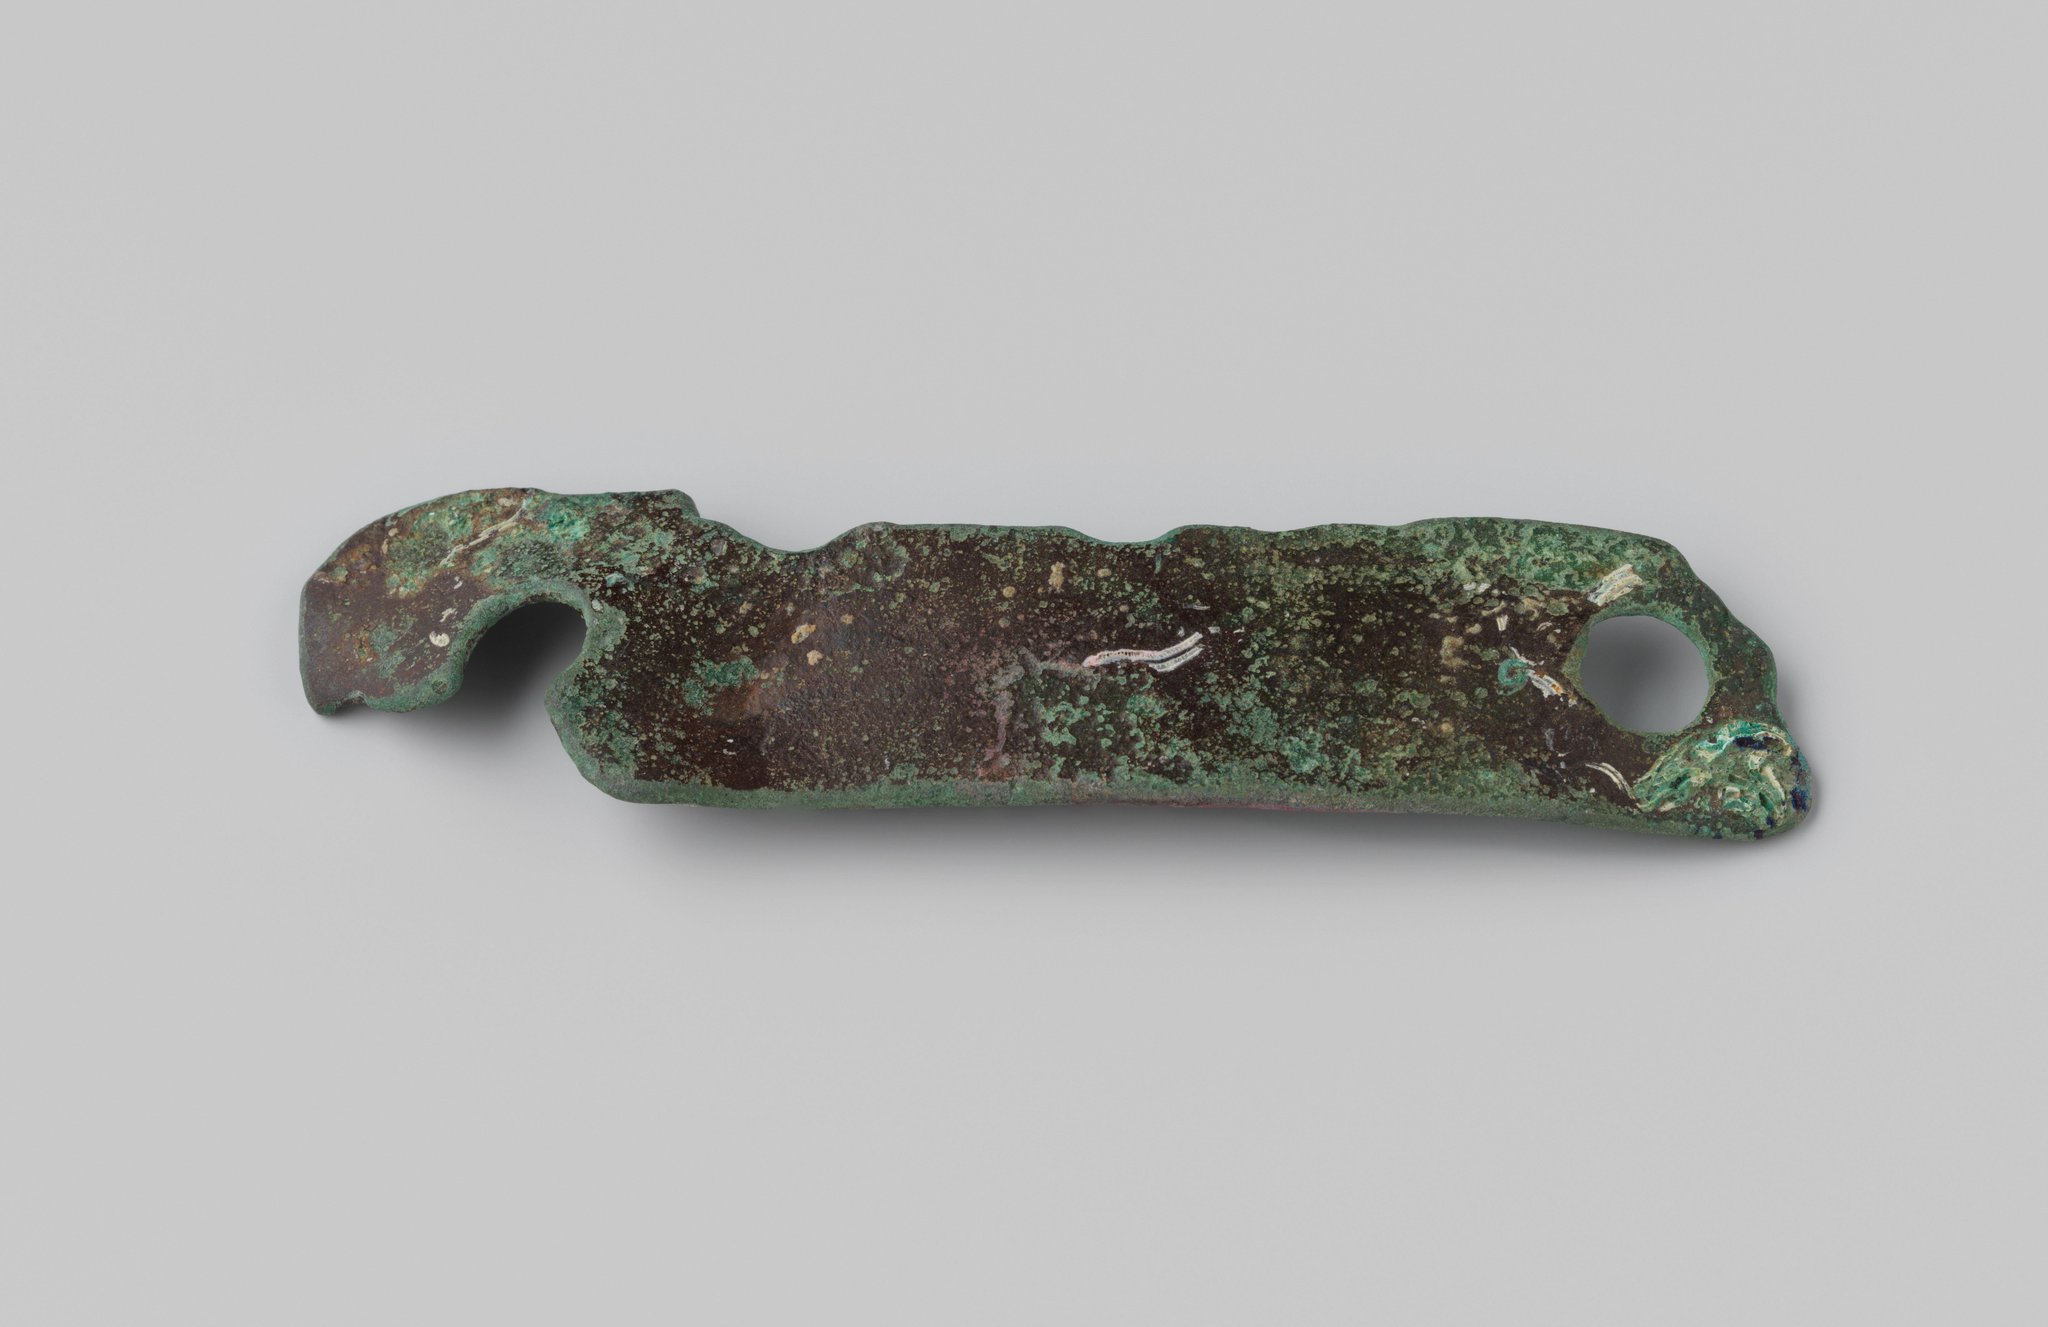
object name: part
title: Onderdeel of hulpstuk afkomstig uit het wrak van de Oost-Indiëvaarder Hollandia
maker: Anonymous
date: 1700-1743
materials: copper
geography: netherlands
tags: verenigde oostindische compagnie, hollandia (schip)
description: Strip-shaped fitting; fragm, eroded, originally angular pattern, flat, 2 ends broken, 2 holes.